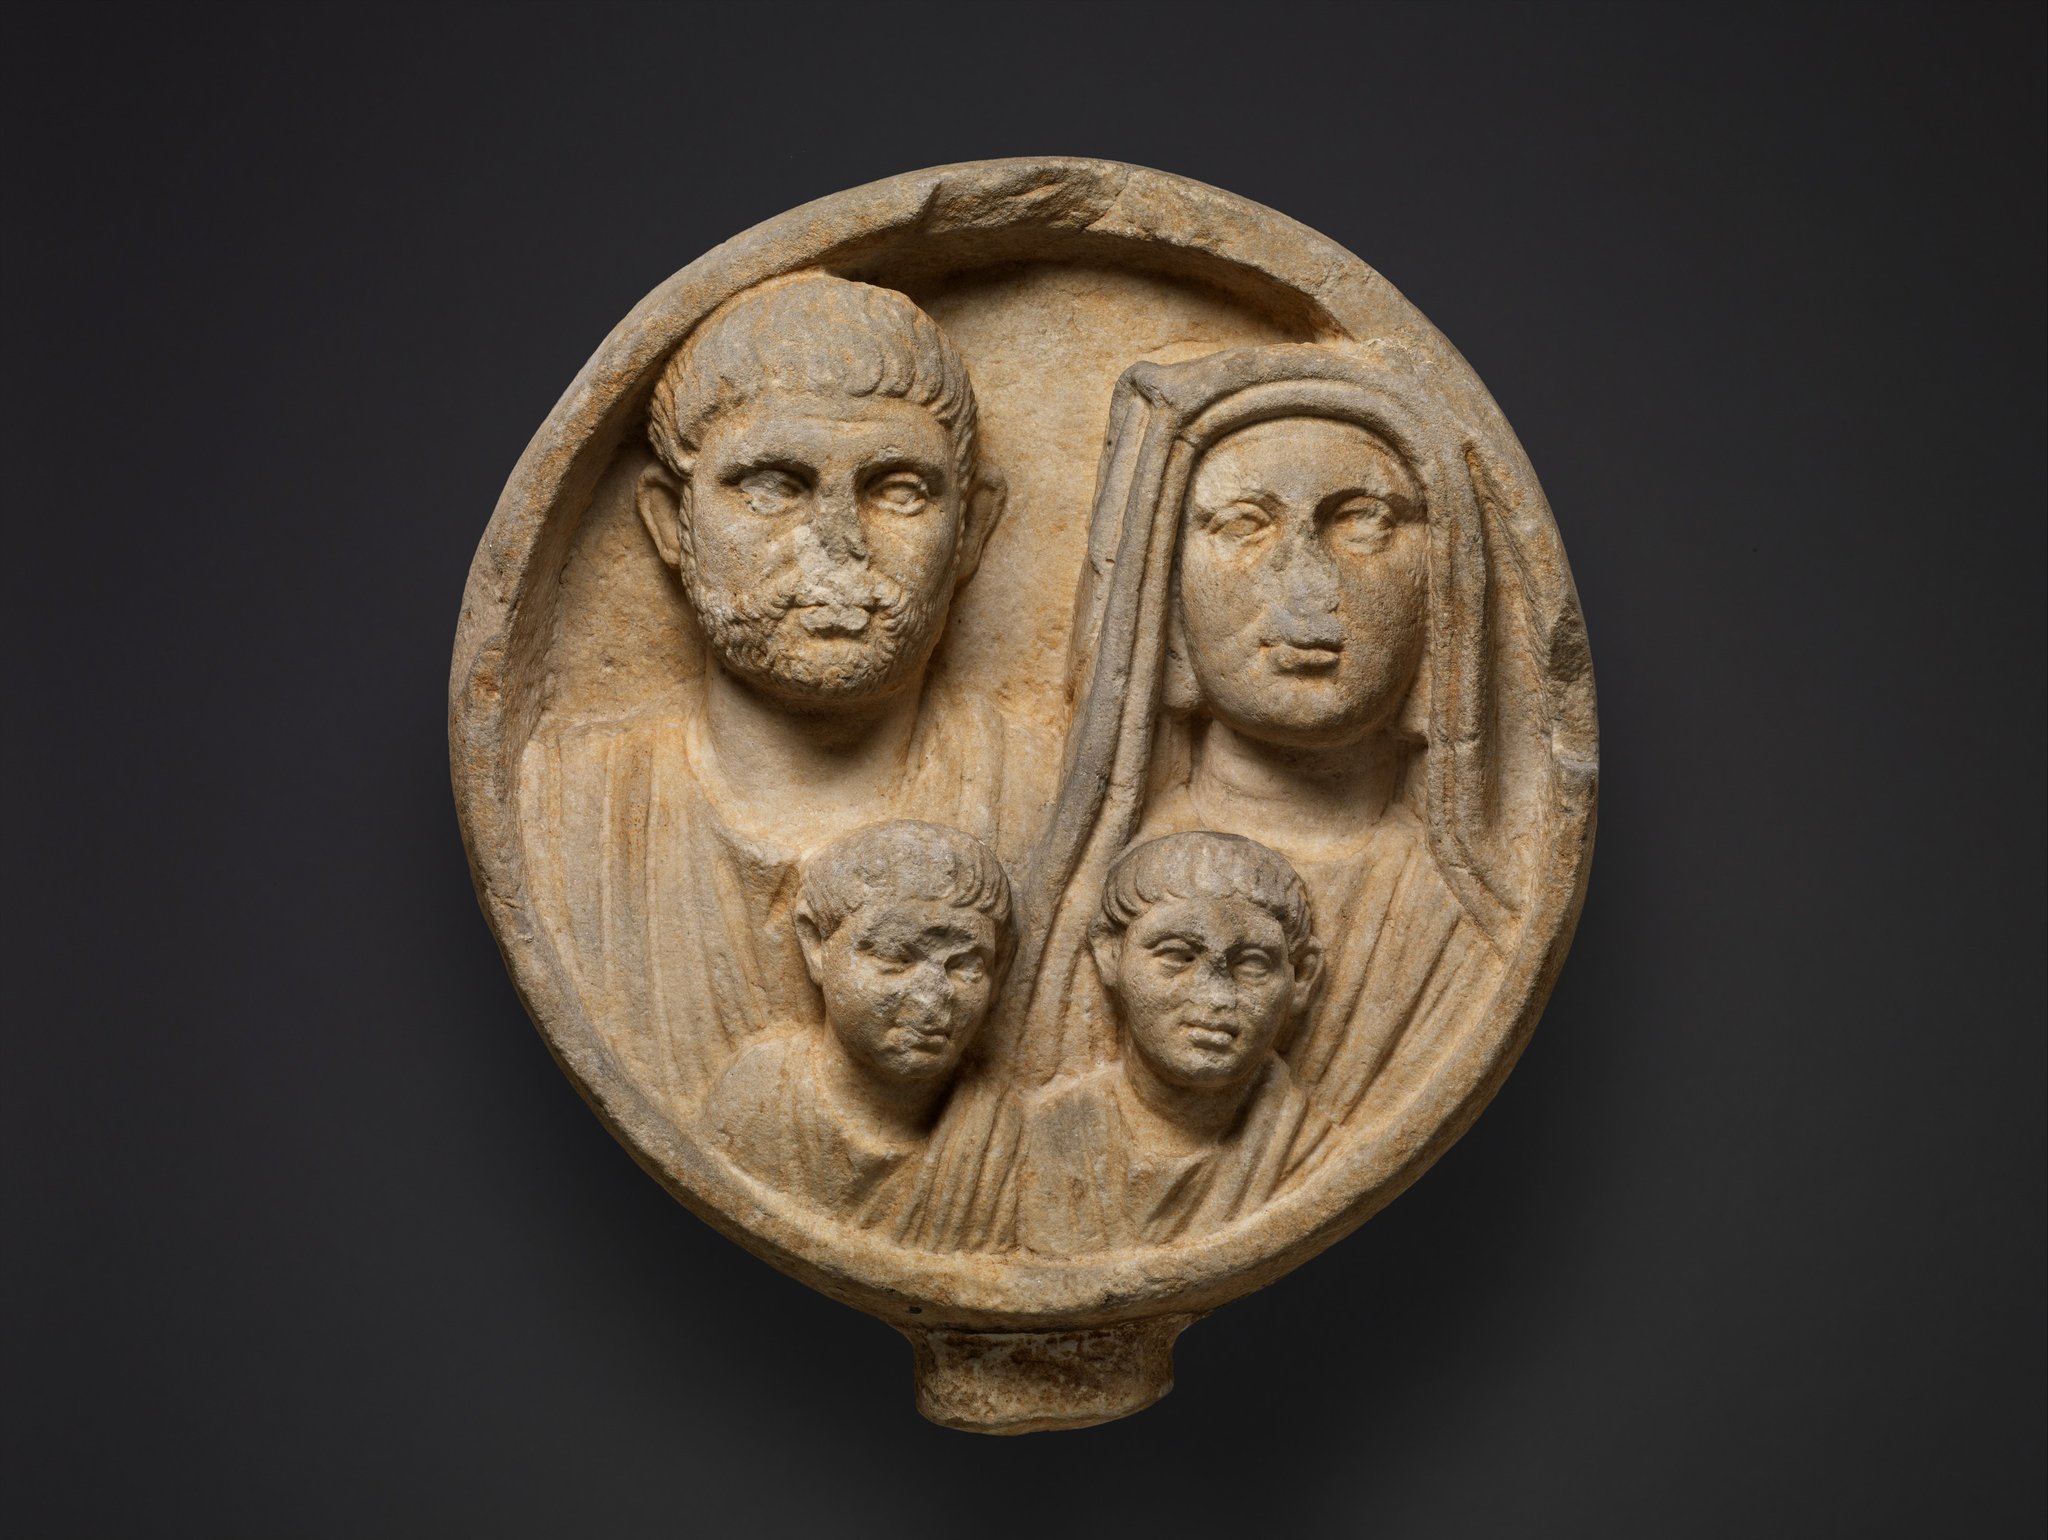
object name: relief tondo with portrait of a family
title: Marble funerary relief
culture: roman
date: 101-300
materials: marble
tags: boys,men,women